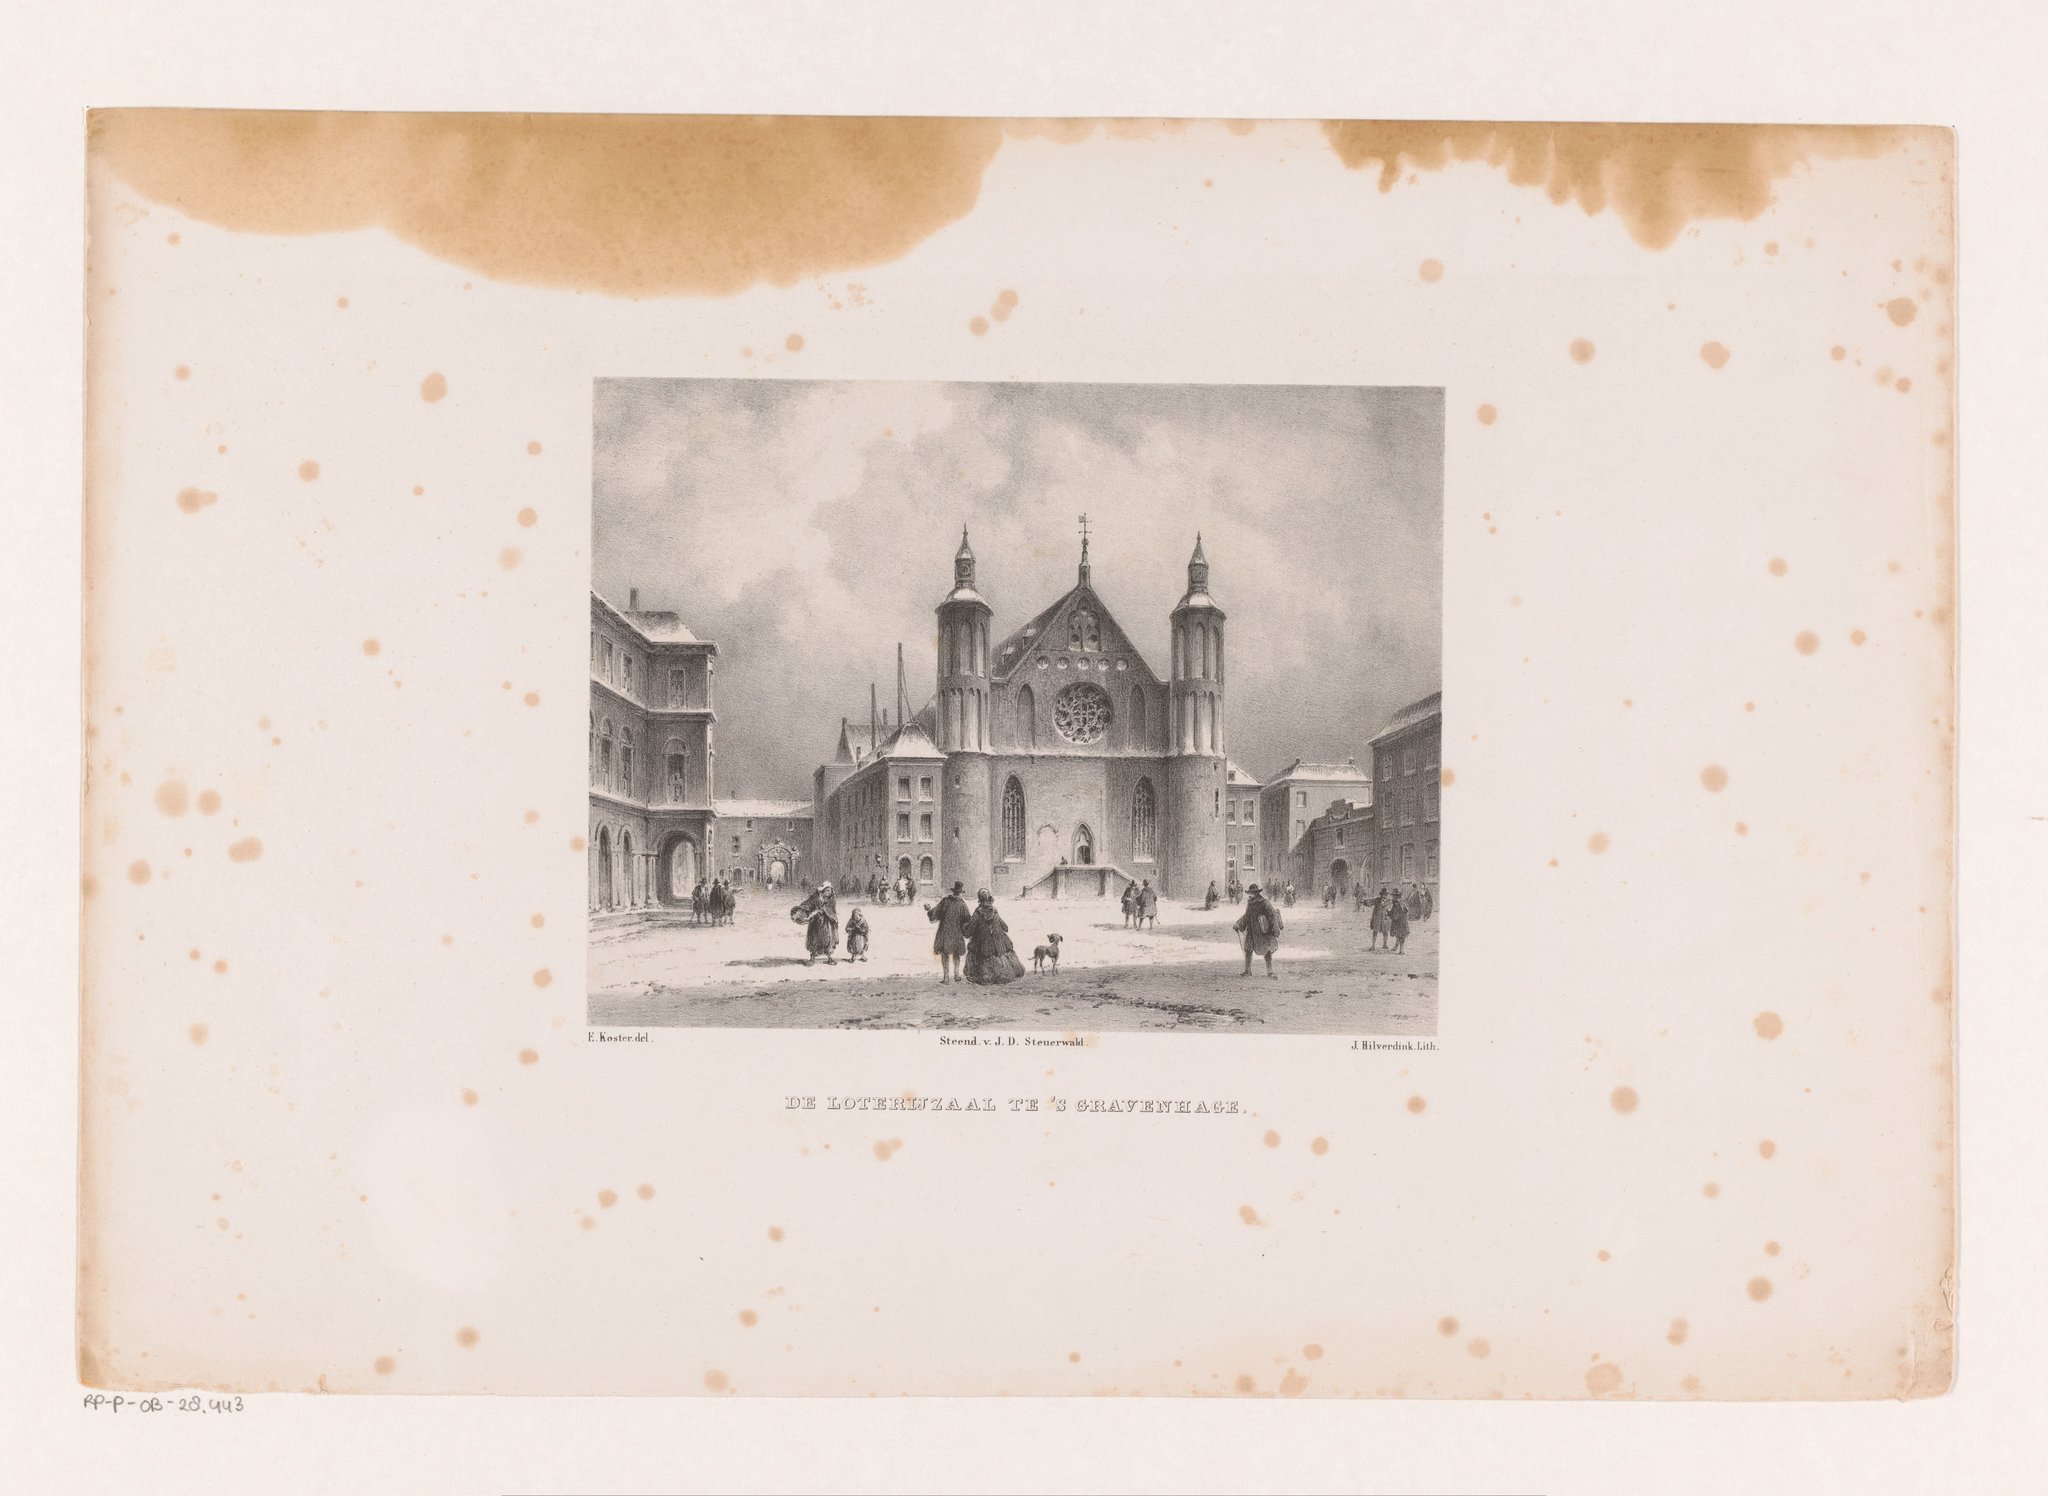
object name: print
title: Loterijzaal op het binnenhof in Den Haag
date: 1858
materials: paper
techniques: lithograph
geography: amsterdam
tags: raffle, lottery, city-view, and landscape with man-made constructions (+ city(-scape) with figures, staffage), market-hall, village square, place (+ city(-scape) with figures, staffage), the hague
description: Deze prent komt uit: Koster, E. 'E. Koster's schetsboek: Nederlandsche Stads- en Havengezichten, uitgegeven onder medewerking van de maatschappij Arti et Amicitiae, Amsterdam, F. Buffa en Zn., e.a.' Amsterdam 1858.